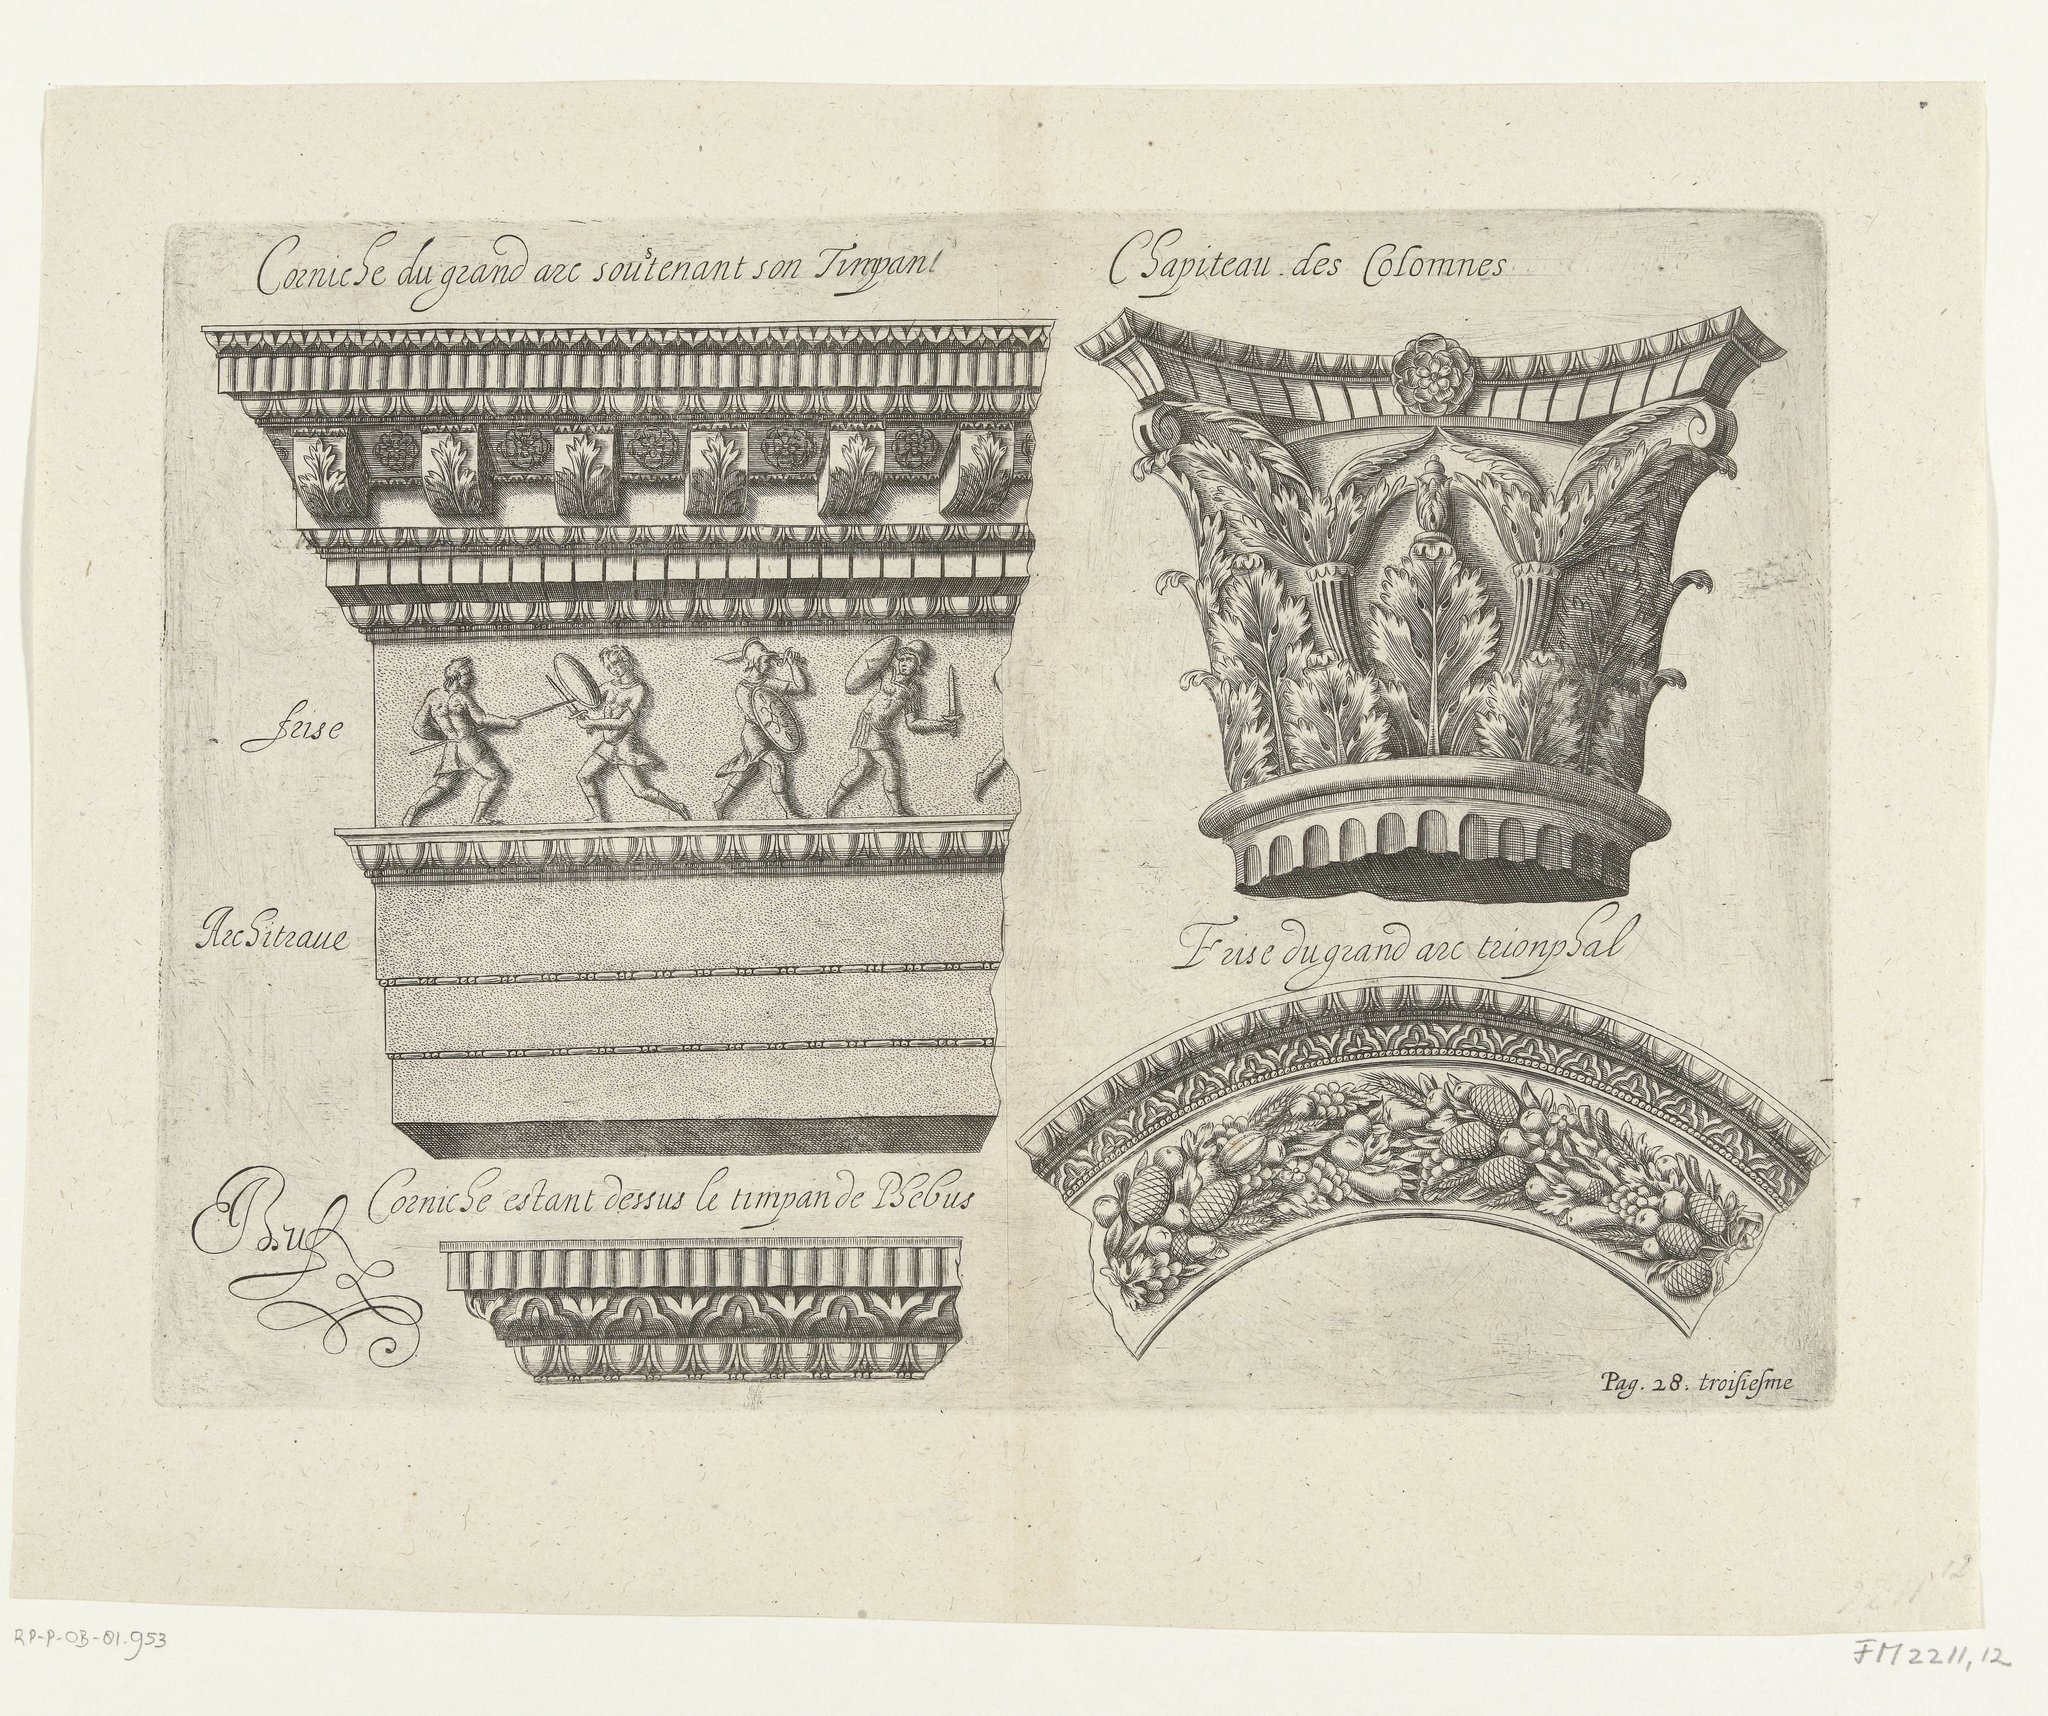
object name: print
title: Corniche du grand arc soustenant son Timpan / Chapiteau des Colomnes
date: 1637-1640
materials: paper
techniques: engraving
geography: france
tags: ornaments ~ art, triumphal arch, piece of sculpture, reproduction of a piece of sculpture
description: Gebruikt als illustratie in: Joseph de la Pisé, Tableau de l'histoire des princes et principauté d'Orange, Den Haag, 1639-1640, p. 28.